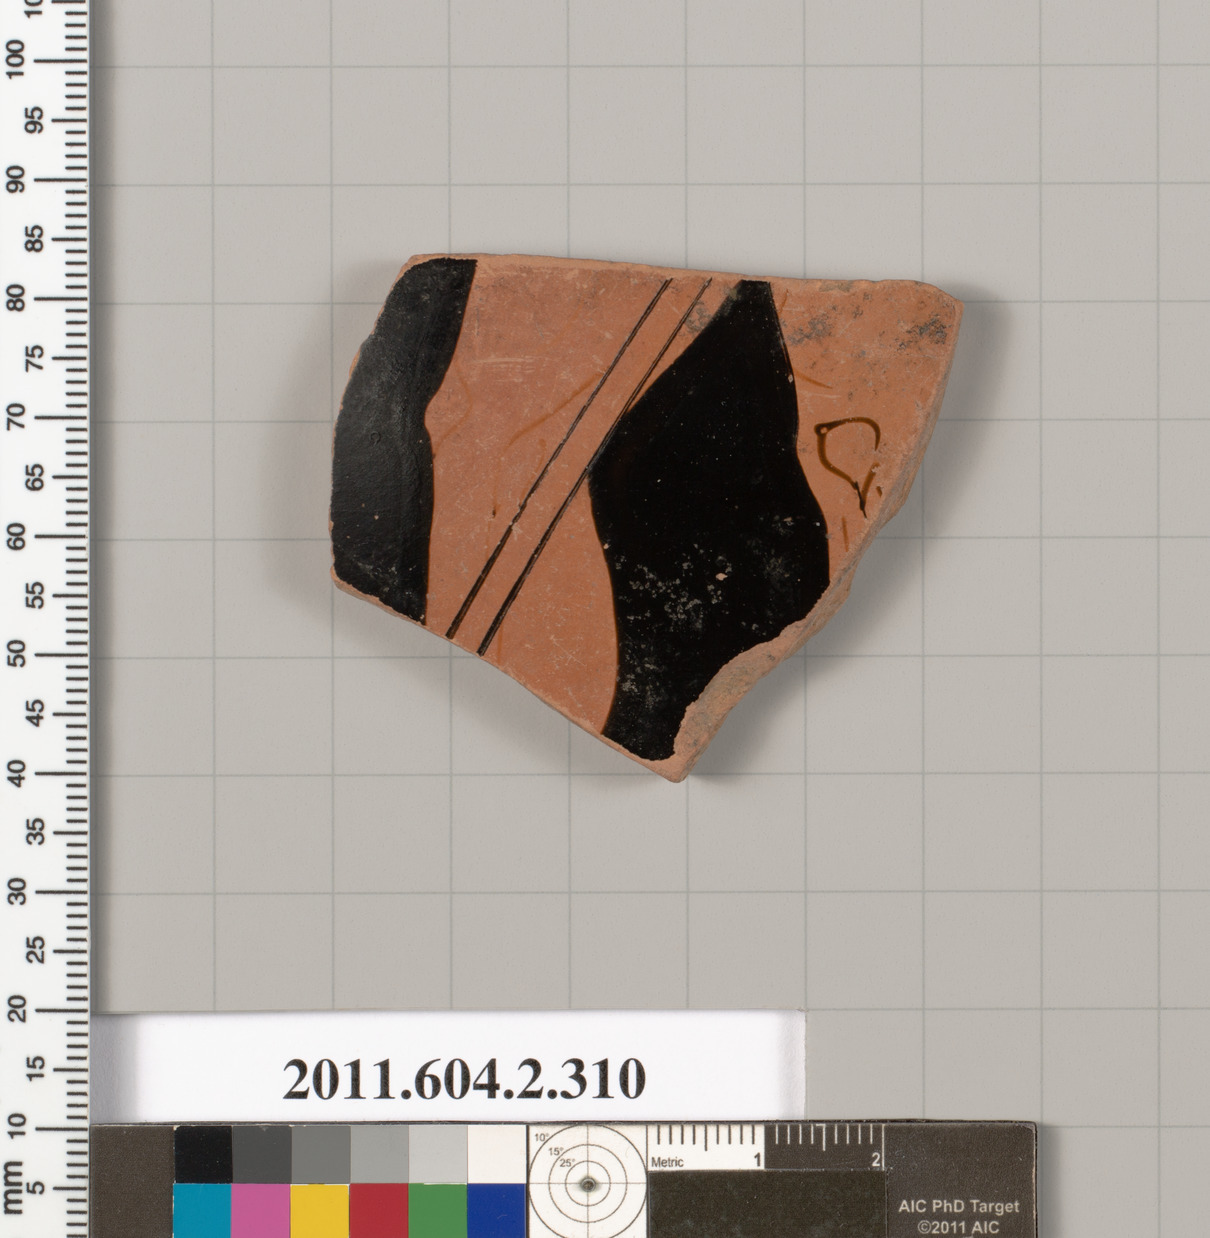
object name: column krater fragment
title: Terracotta fragment of a column-krater (bowl for mixing wine and water)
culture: greek, attic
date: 460-440 BCE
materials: terracotta